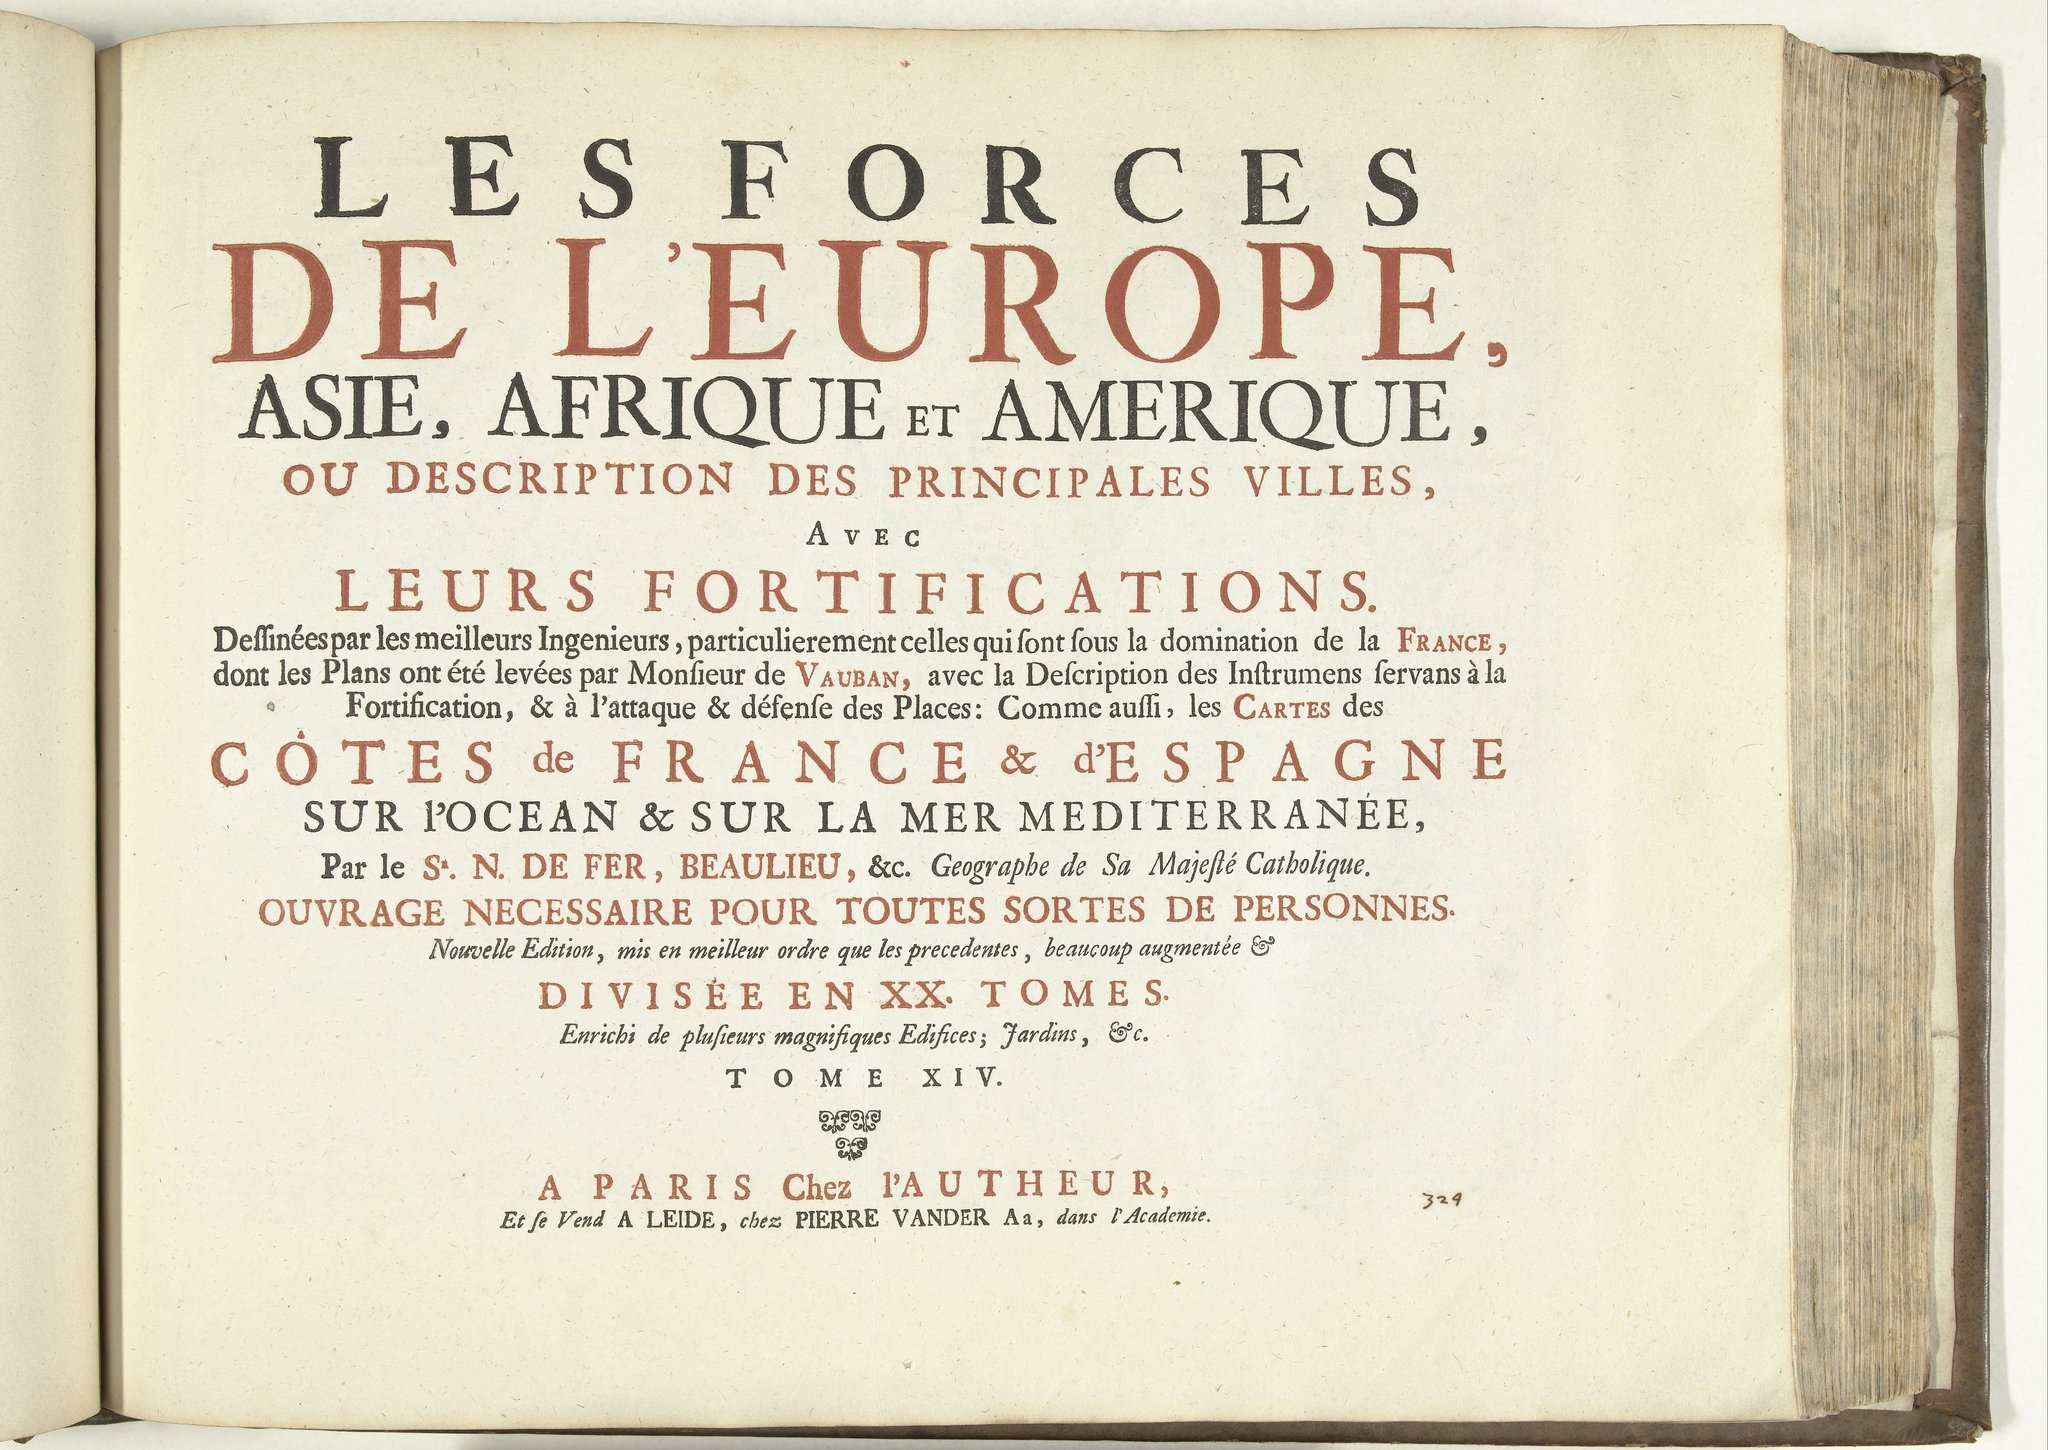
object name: titelblad, titelpagina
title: Titelpagina voor het prentwerk: Les Forces de l'Europe, Asie, Afrique et Amerique (...) Comme aussi les Cartes des Côtes de France et d'Espagne (deel XIV), 1726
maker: pieter van der aa (i)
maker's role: printer, publisher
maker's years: 1659-1733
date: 1726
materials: paper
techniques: letterpress printing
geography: leiden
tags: spaanse successieoorlog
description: Titelpagina gedrukt in zwart en rood voor deel XIV van het prentwerk Les Forces de l'Europe, Asie, Afrique et Amerique ... Comme aussi les Cartes des Côtes de France et d'Espagne, 1726. Dit tweede deel van het prentwerk bestaat uit 271 met de hand genummerde platen van vermaarde sterke steden en vestingen in het kader van de Spaanse Successieoorlog 1701-1713. Voor het merendeel zijn deze platen gekopieerd naar de anonieme Franse platen van vermaarde sterke steden en vestingen: in Les forces de l'Europe en in: Le theatre de la guerre, dans les Pays-Bas, beide oorspronkelijk uitgegeven door Nicolas de Fer te Parijs (1693-1697) in het kader van de Negenjarige Oorlog. Titel in het Frans.